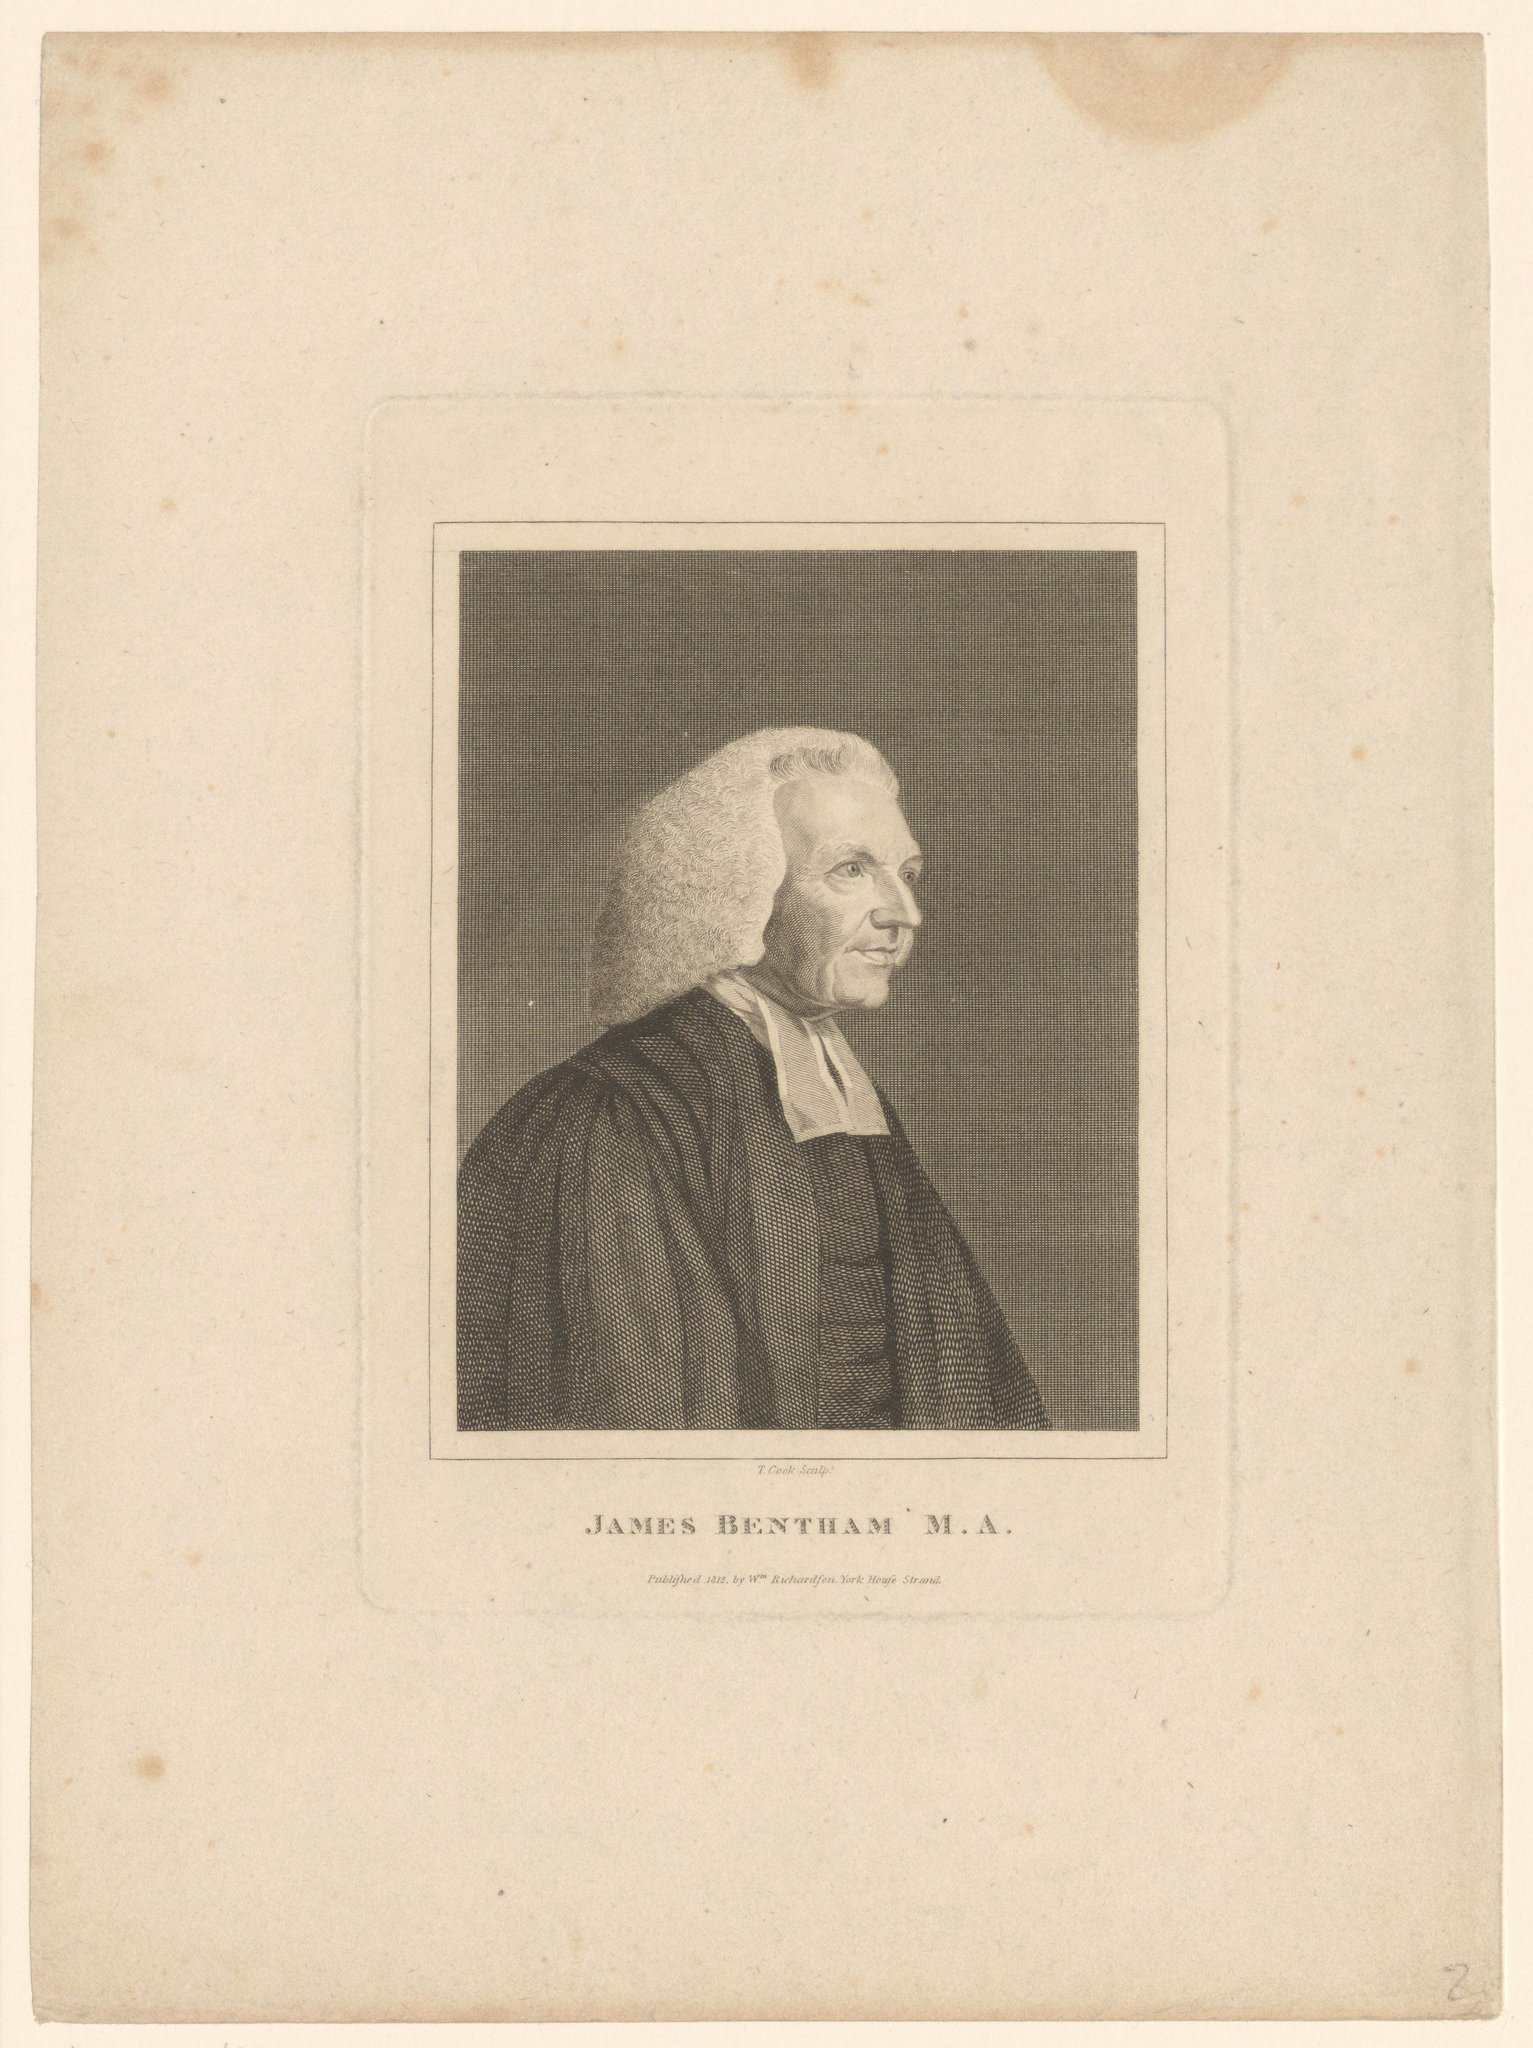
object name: print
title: Portret van James Bentham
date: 1812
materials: paper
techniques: engraving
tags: historical persons, portrait of a writer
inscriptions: collector's mark: Lugt 2228